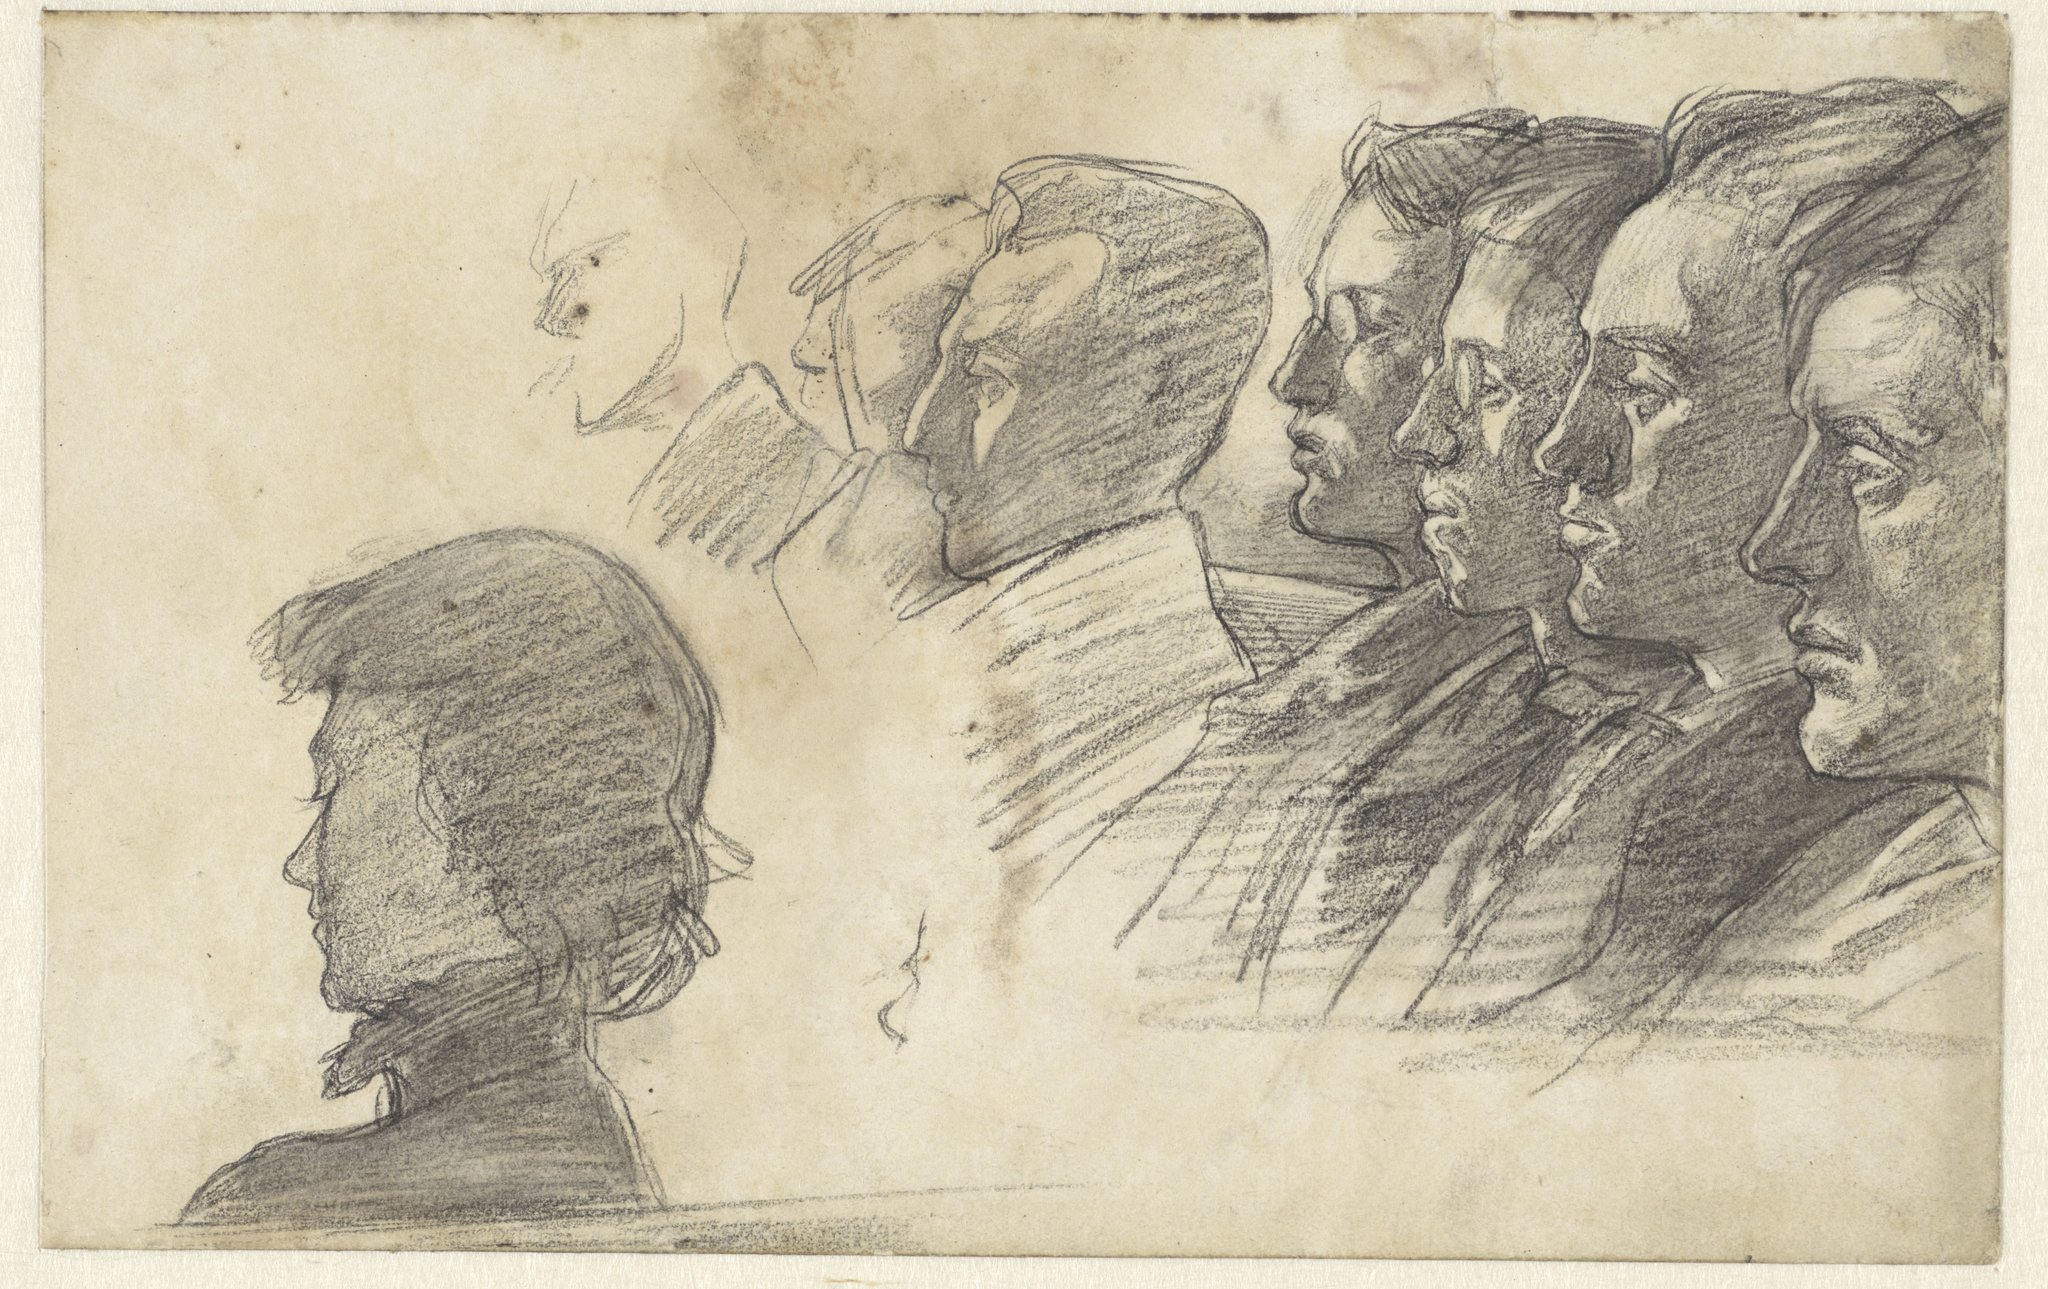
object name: drawing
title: Reeks koppen van publiek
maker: jac van looij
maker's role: draughtsman, painter, print maker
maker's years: 1855-1930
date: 1865-1930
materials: chalk, paper